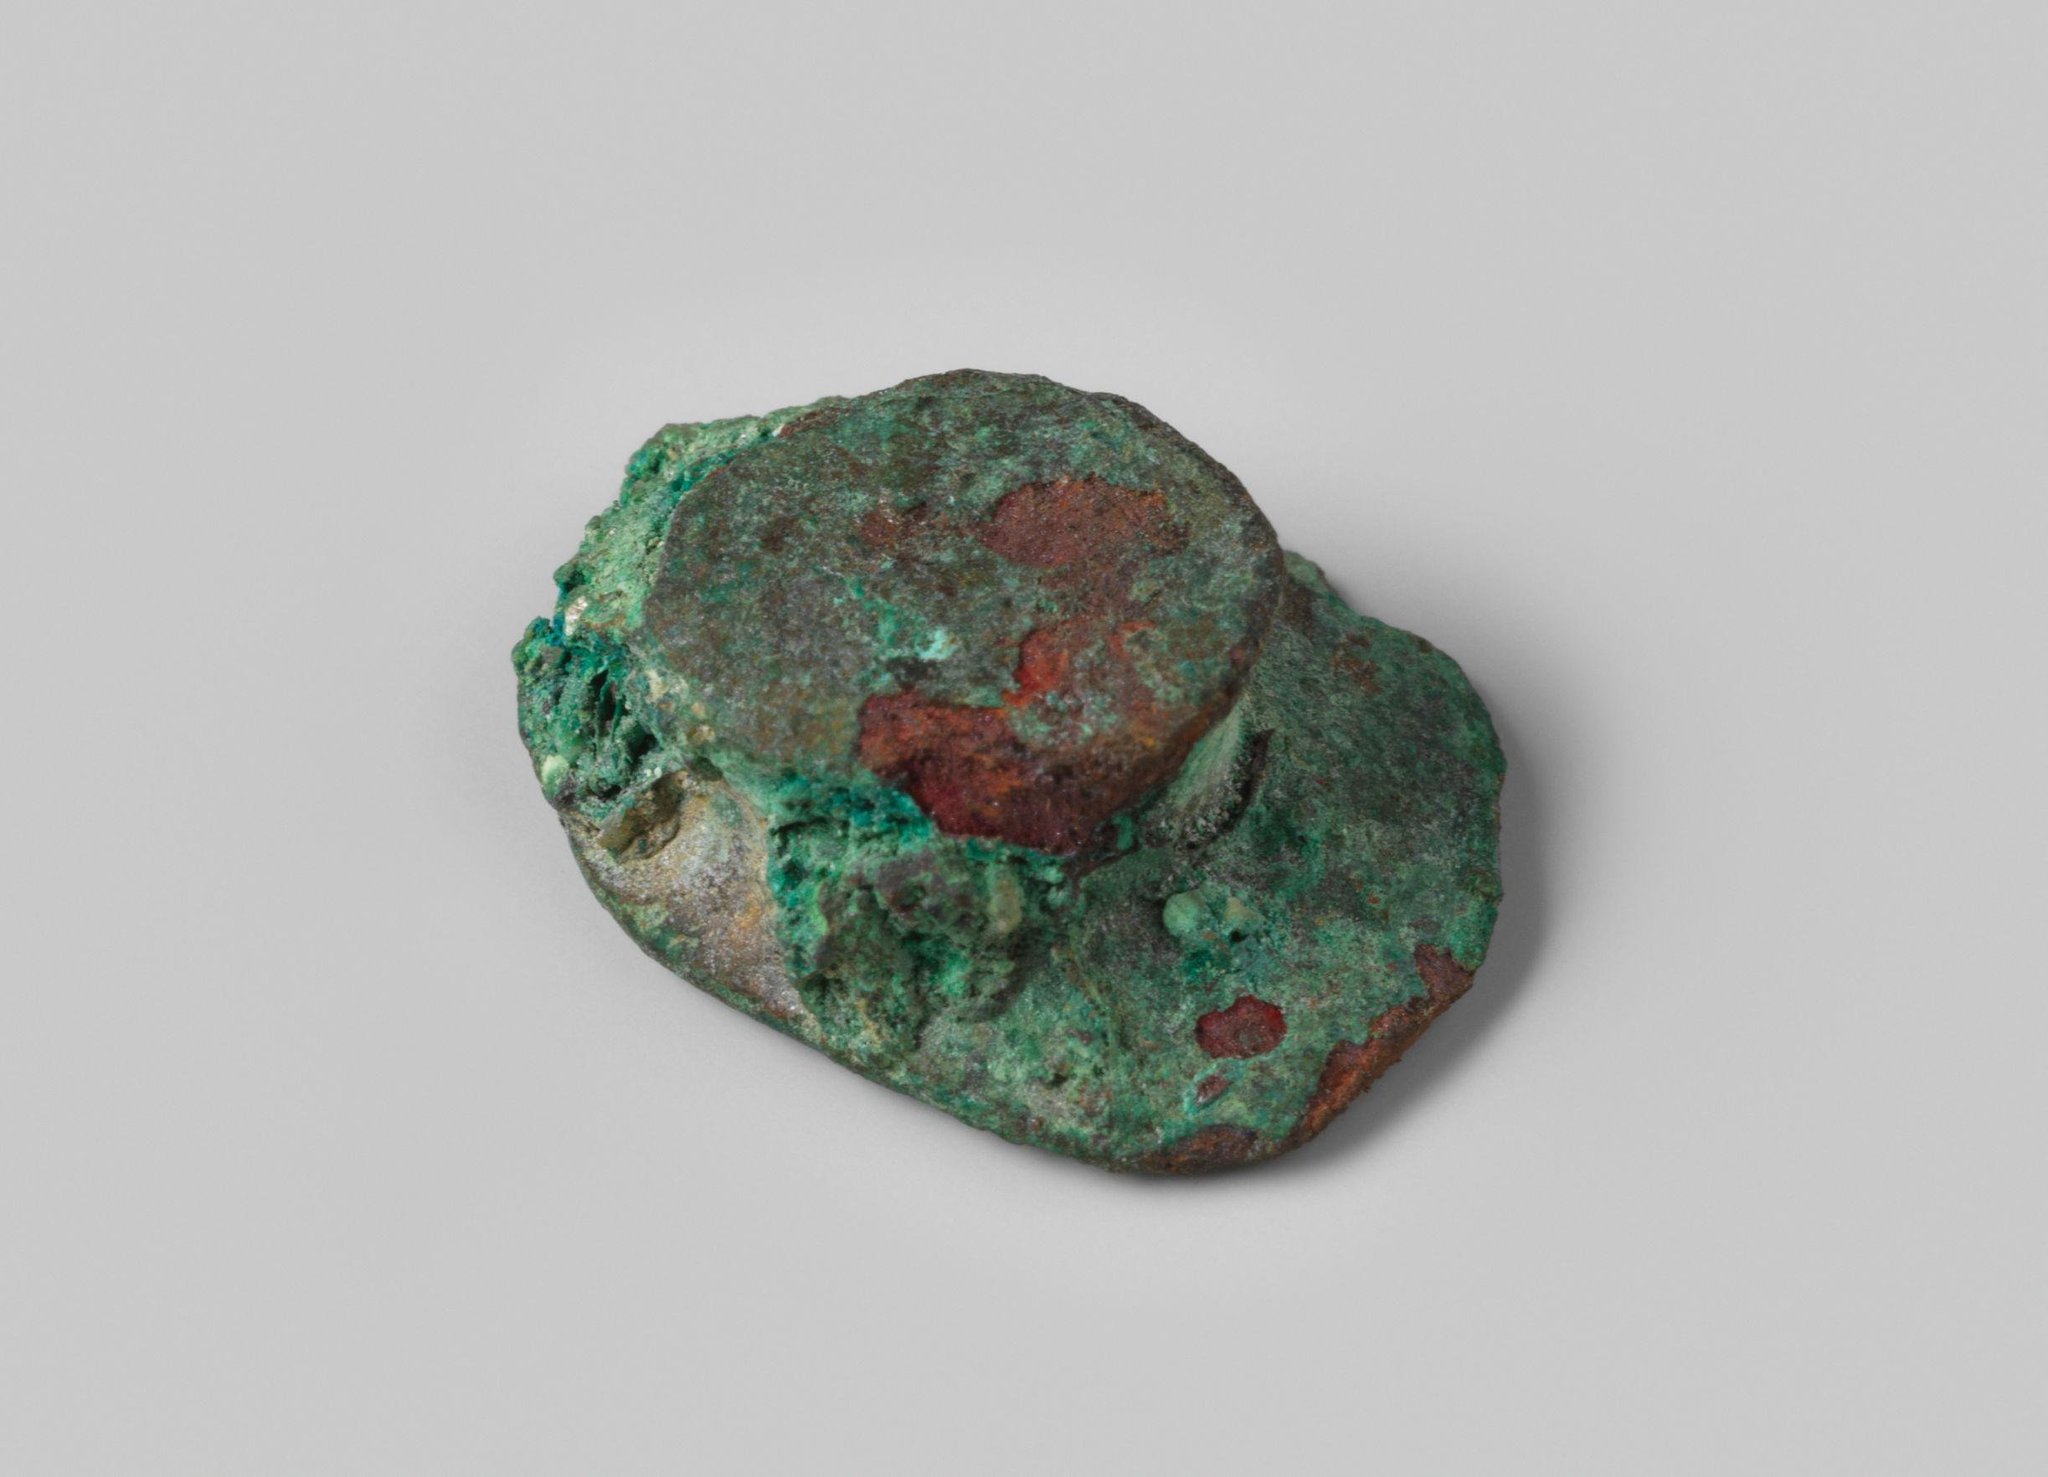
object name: button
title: Knoop uit het wrak van de Oostindiëvaarder Hollandia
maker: Anonymous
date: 1700-1743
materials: copper